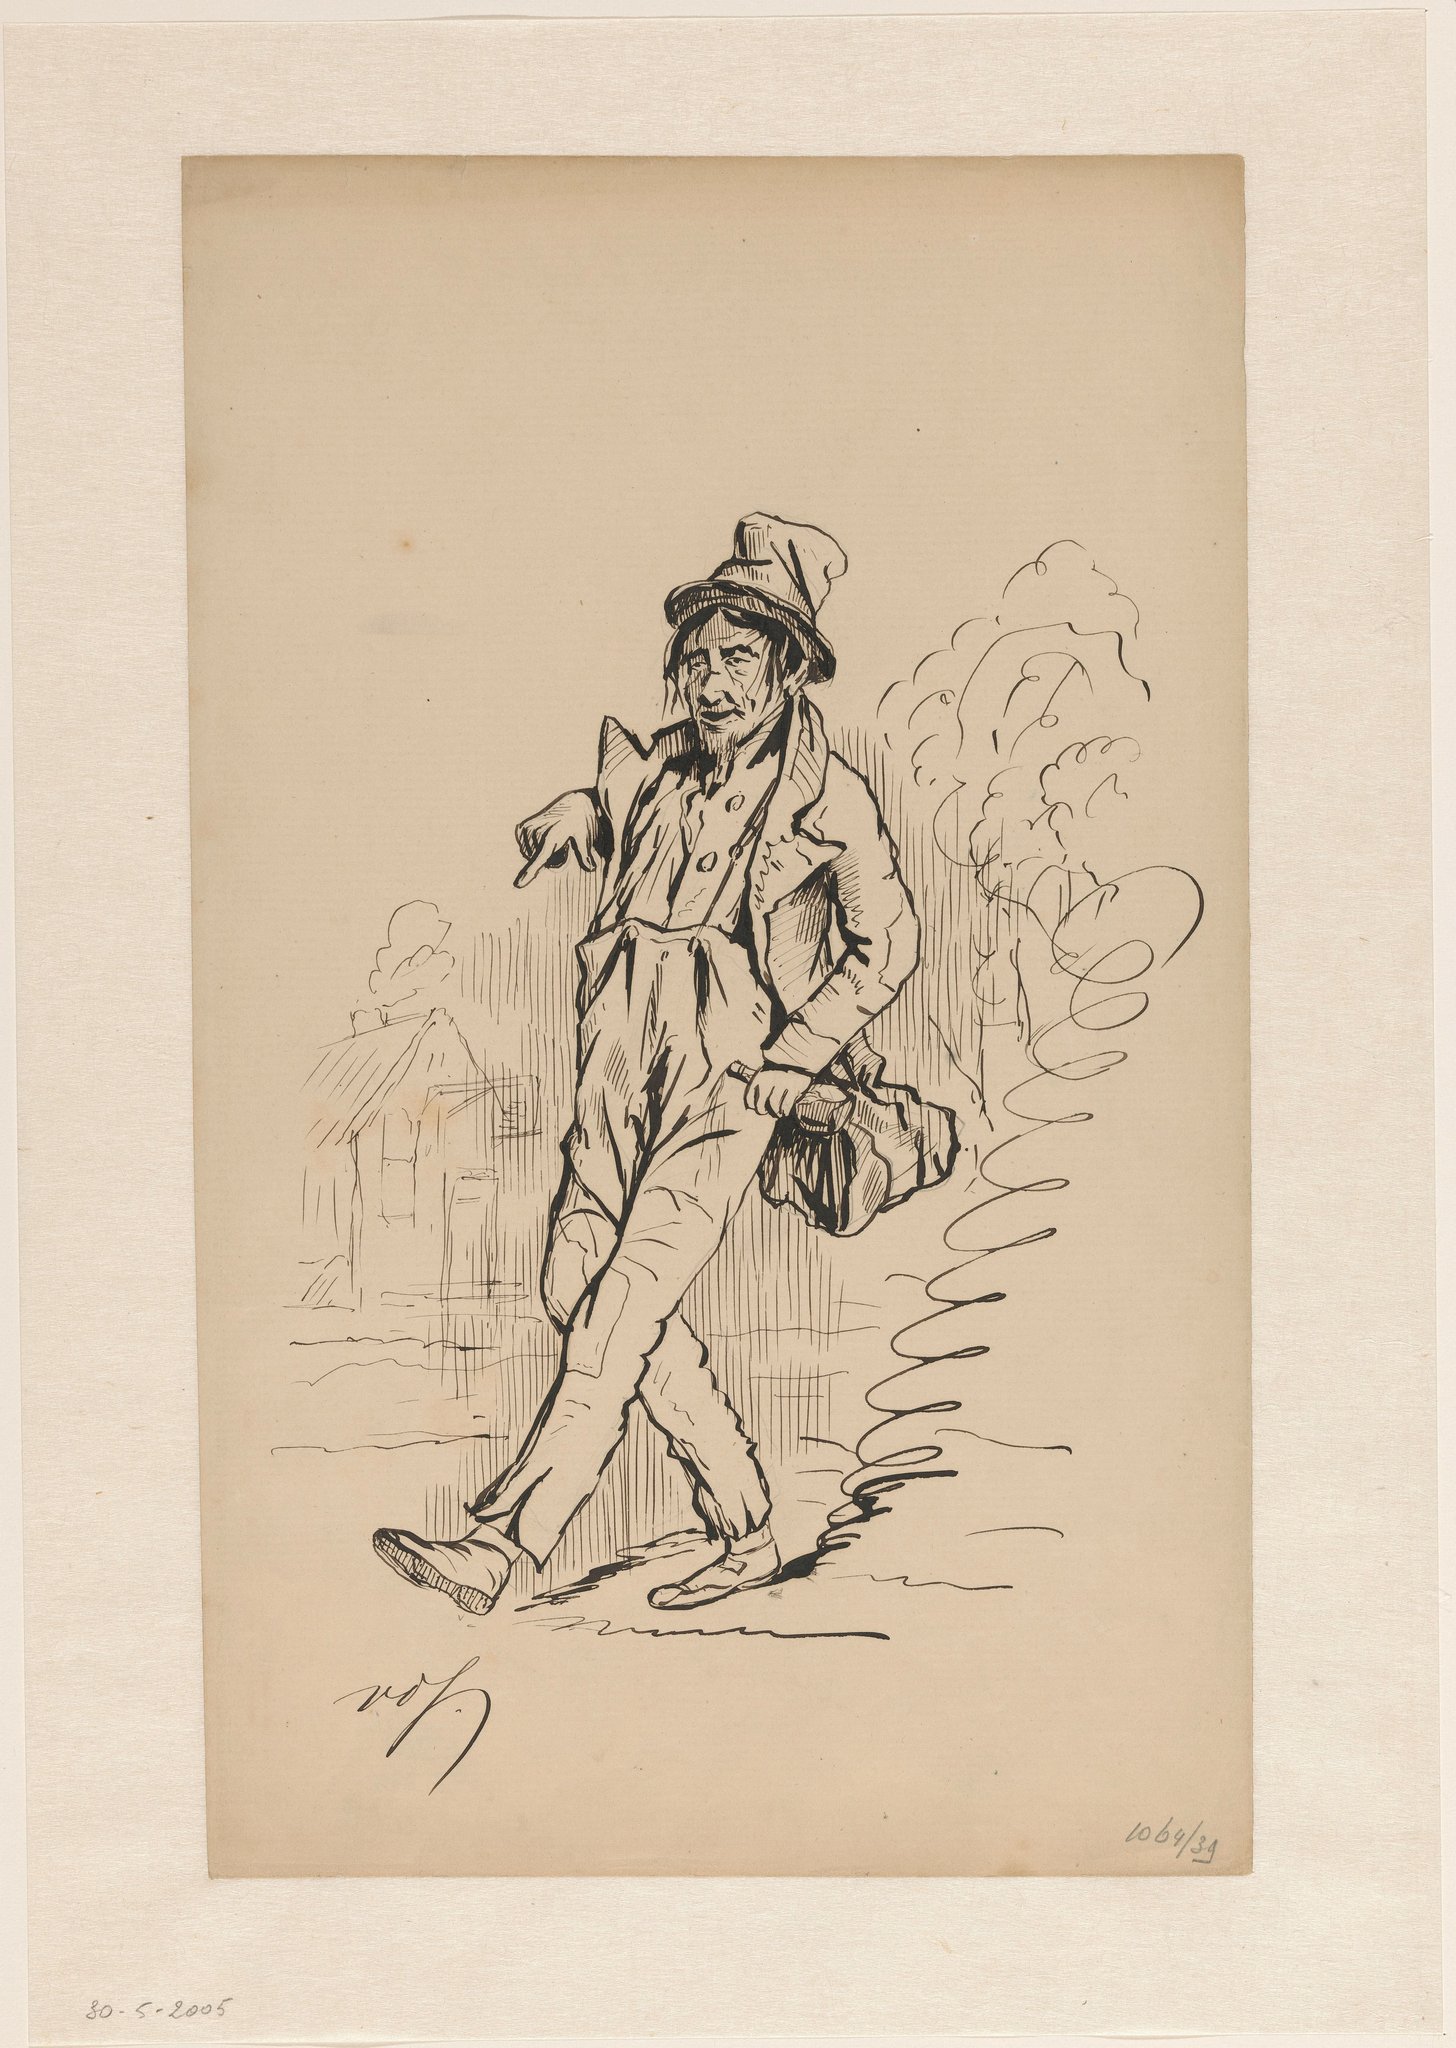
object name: drawing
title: Dronkeman met hoge hoed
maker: monogrammist vdg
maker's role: draughtsman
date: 1800-1900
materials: ink, paper, pencil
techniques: pen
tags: drunkard